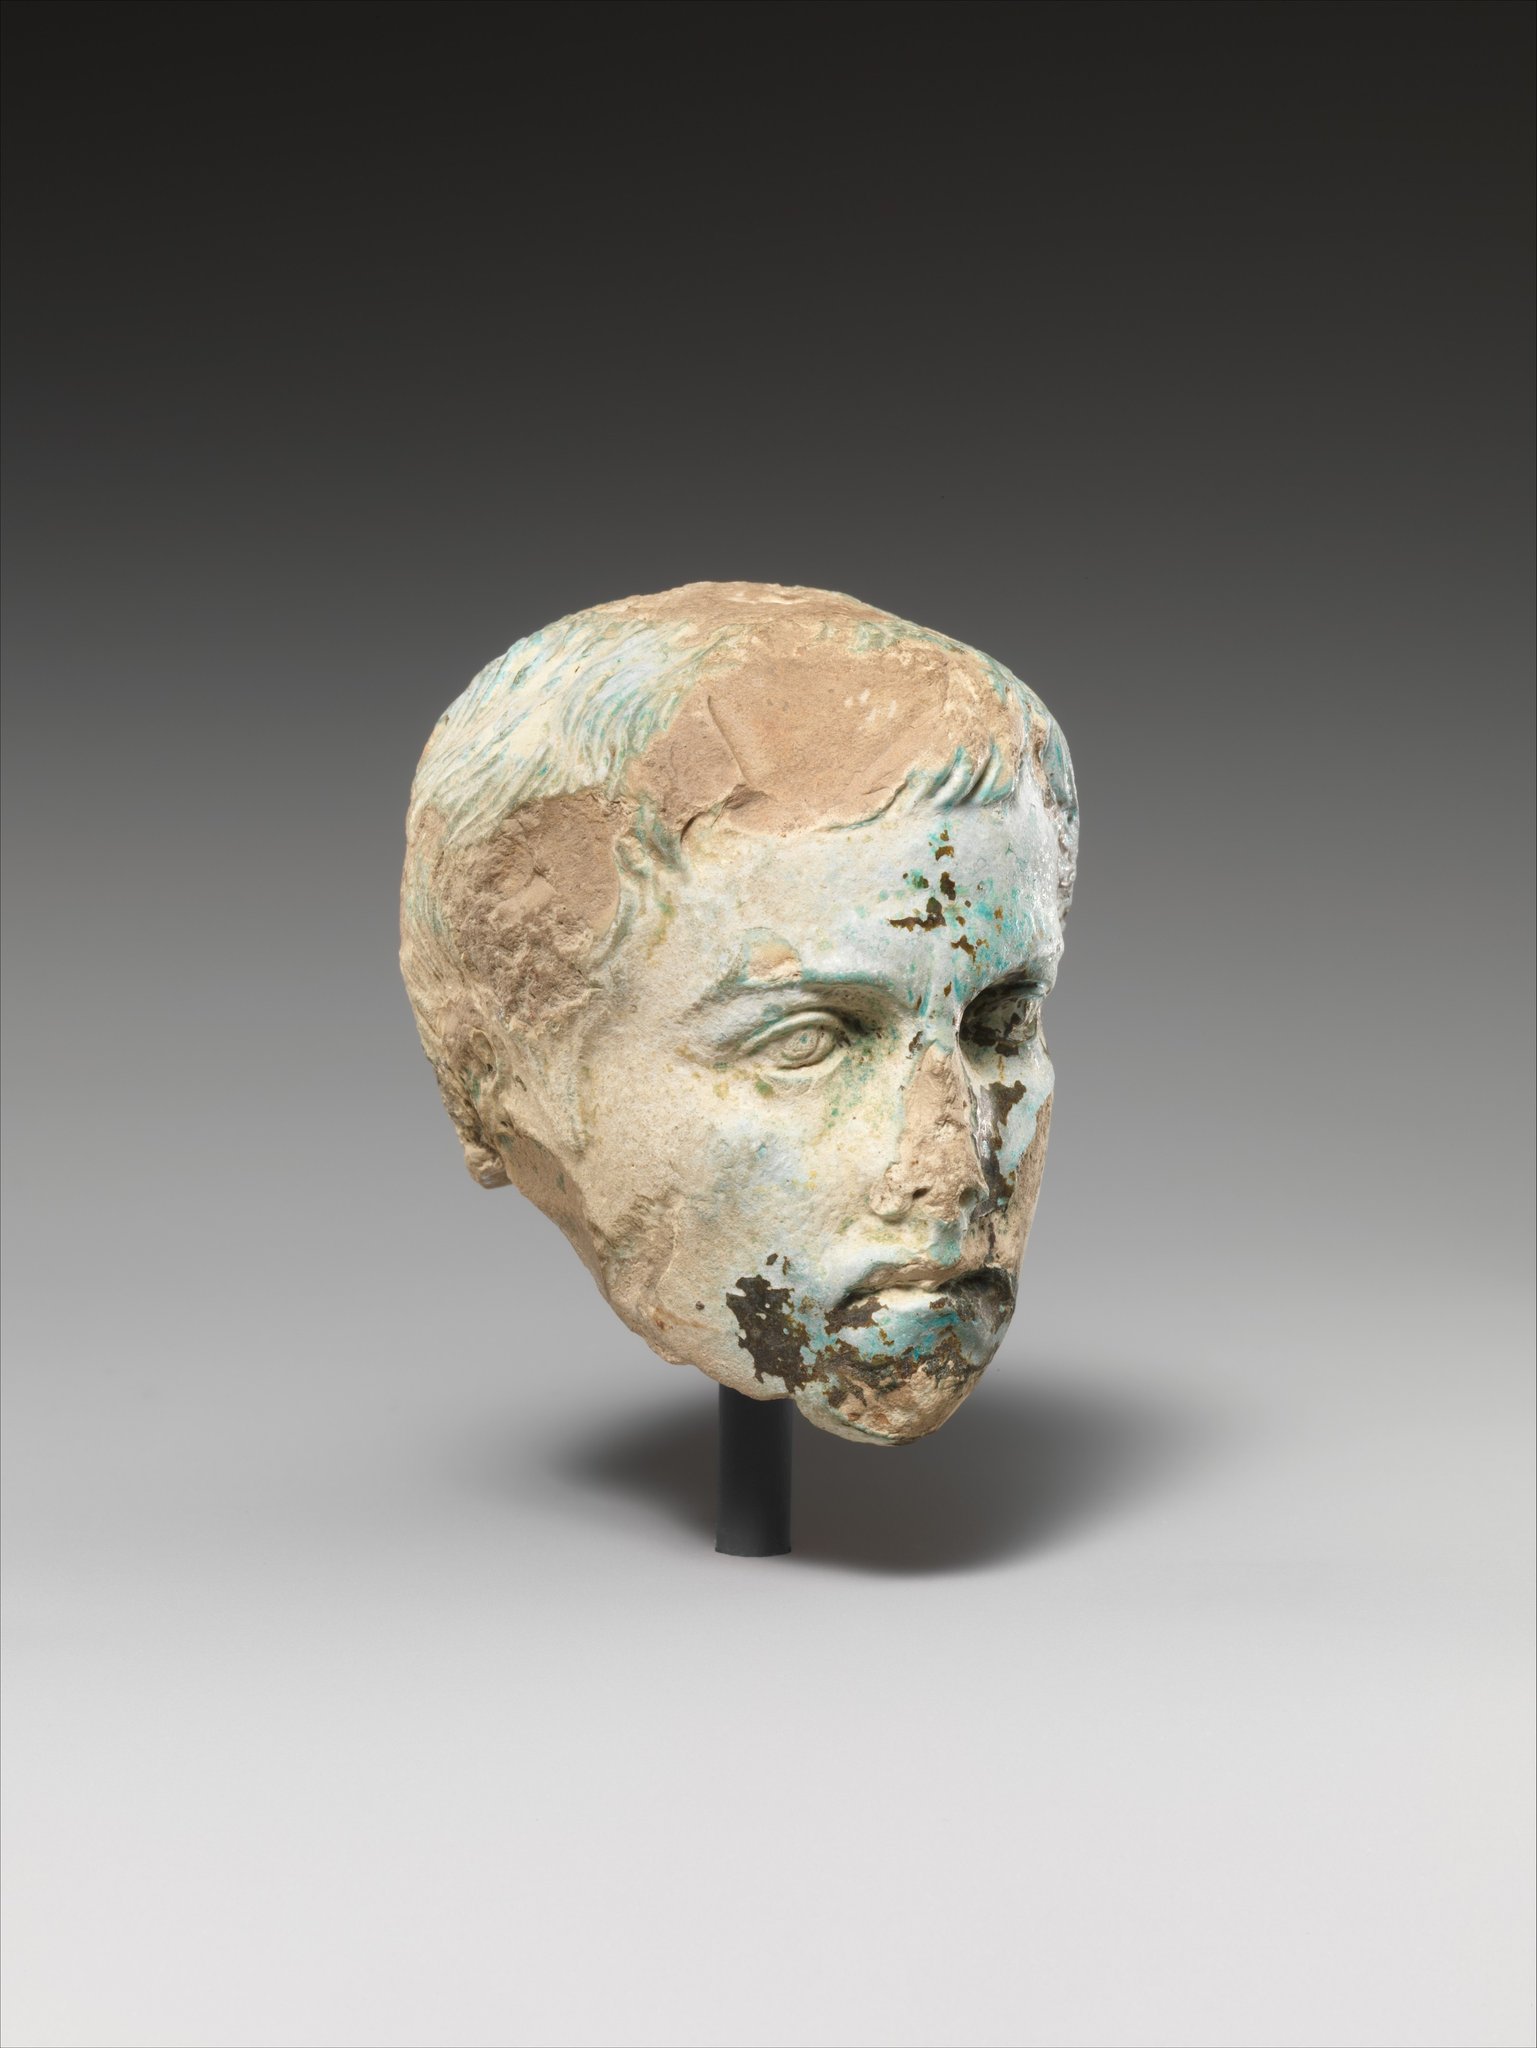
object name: head, augustus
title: Head of Augustus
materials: faience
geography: memphite region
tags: heads,men